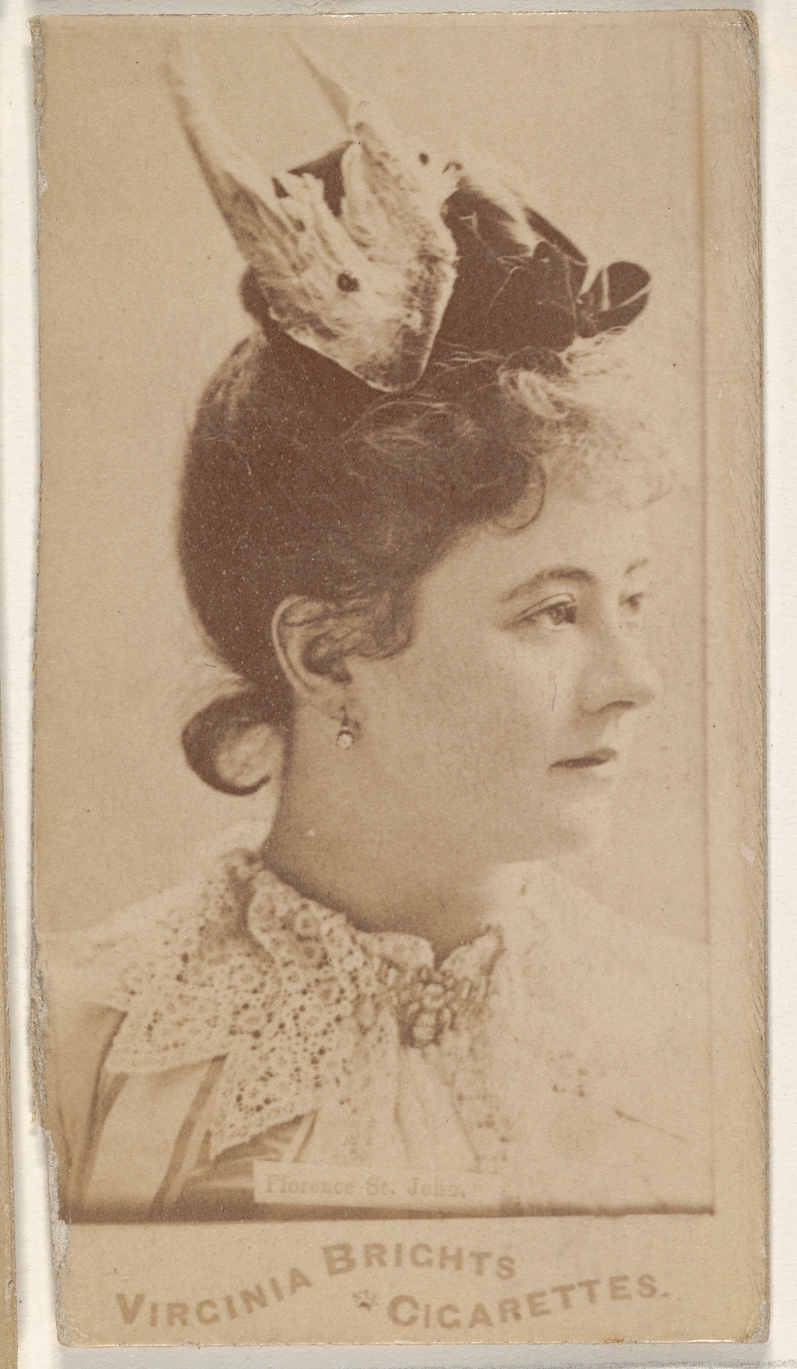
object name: photograph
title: Florence St. John, from the Actors and Actresses series (N45, Type 1) for Virginia Brights Cigarettes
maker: allen & ginter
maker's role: publisher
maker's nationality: american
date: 1888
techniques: albumen silver print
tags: portraits,women,actresses